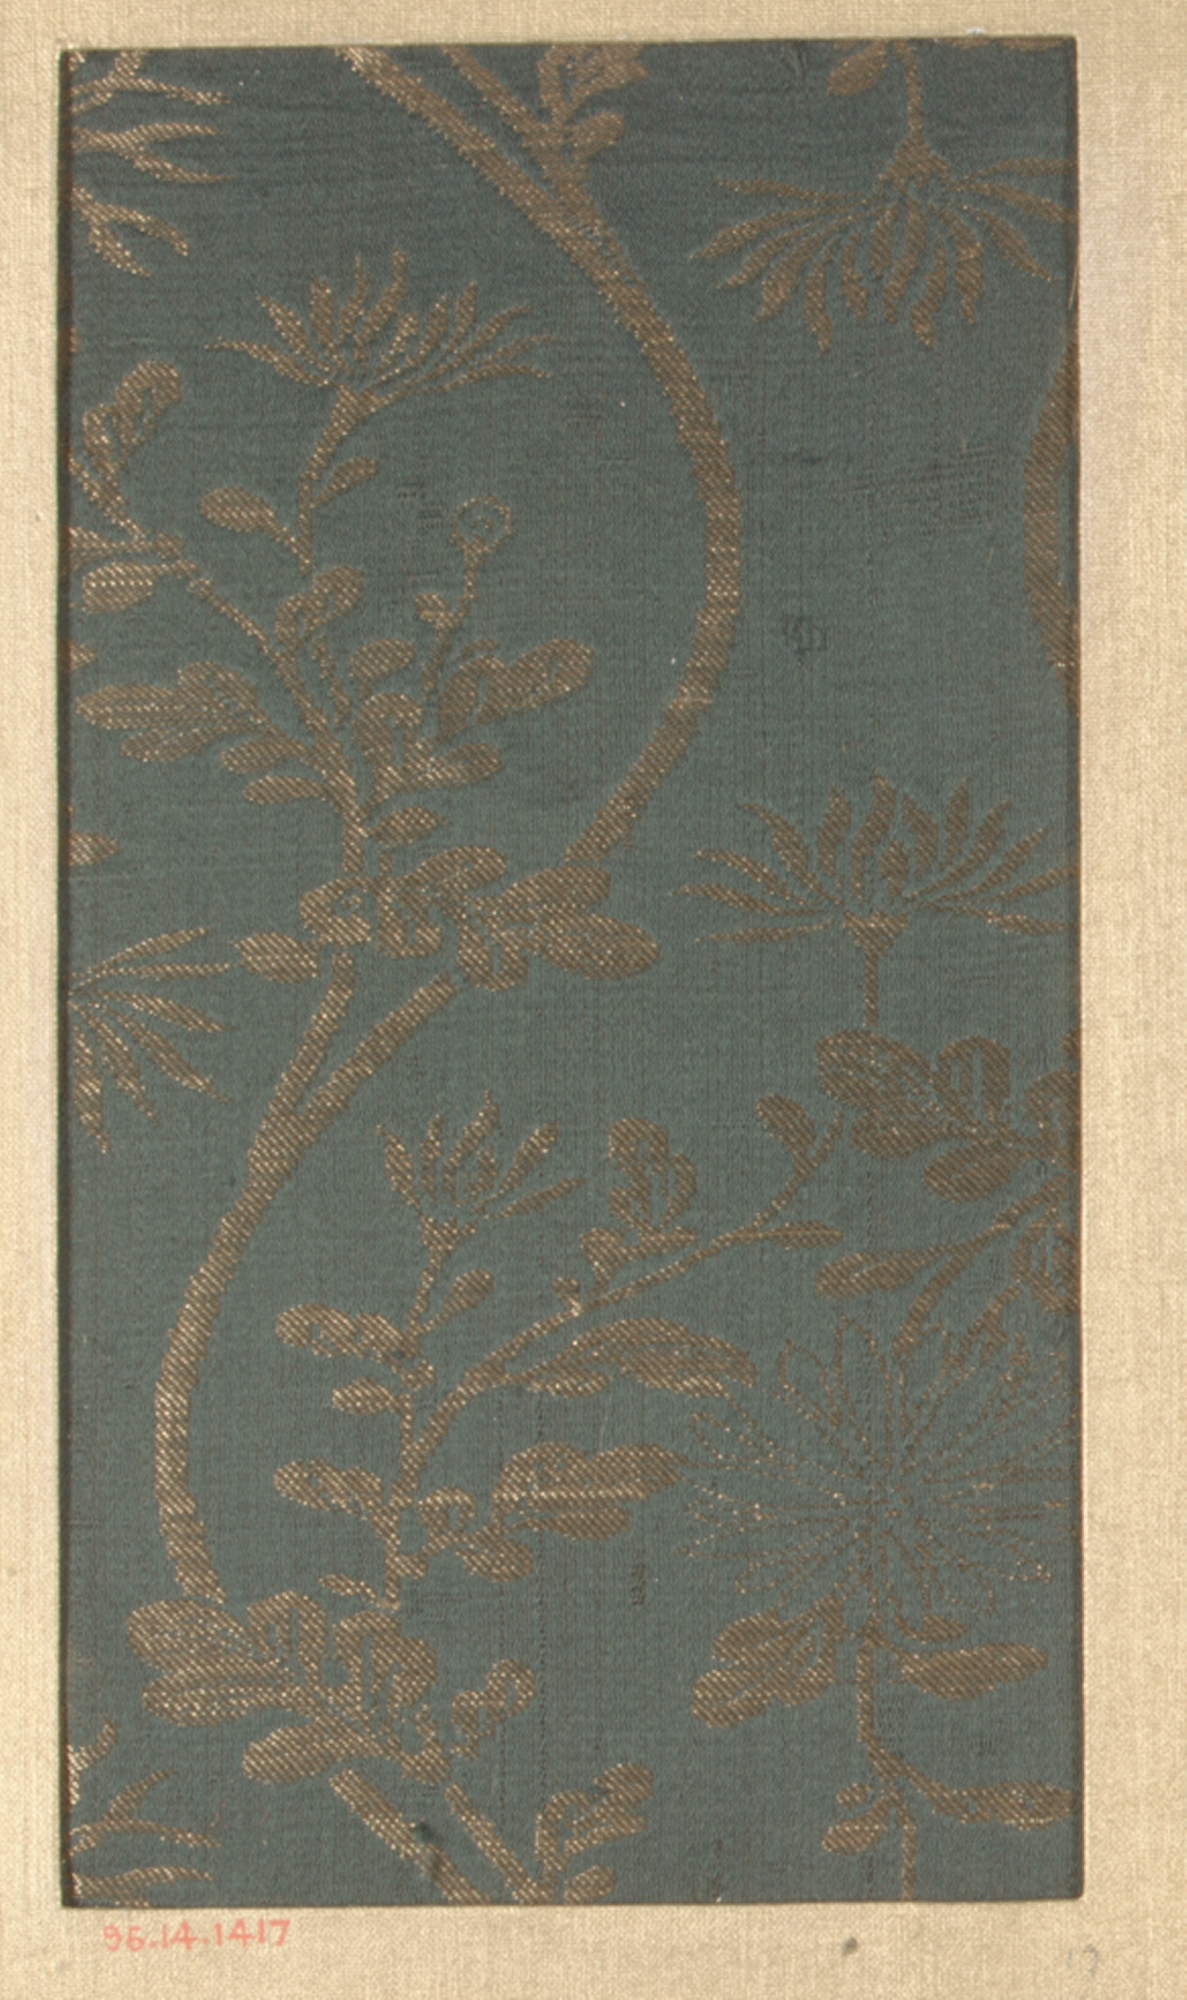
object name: piece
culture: japanese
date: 1701-1900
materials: silk